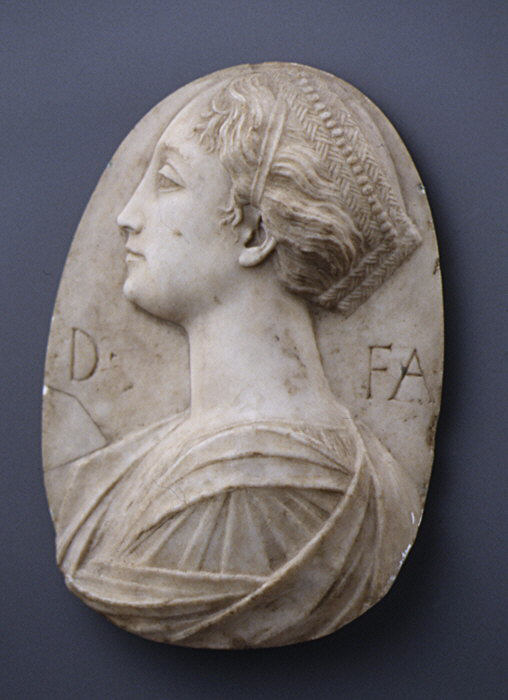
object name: relief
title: Diva Faustina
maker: mino da fiesole (mino di giovanni)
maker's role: artist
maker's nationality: italian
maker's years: 1429-1484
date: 1401-1500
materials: marble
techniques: gilding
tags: profiles,women